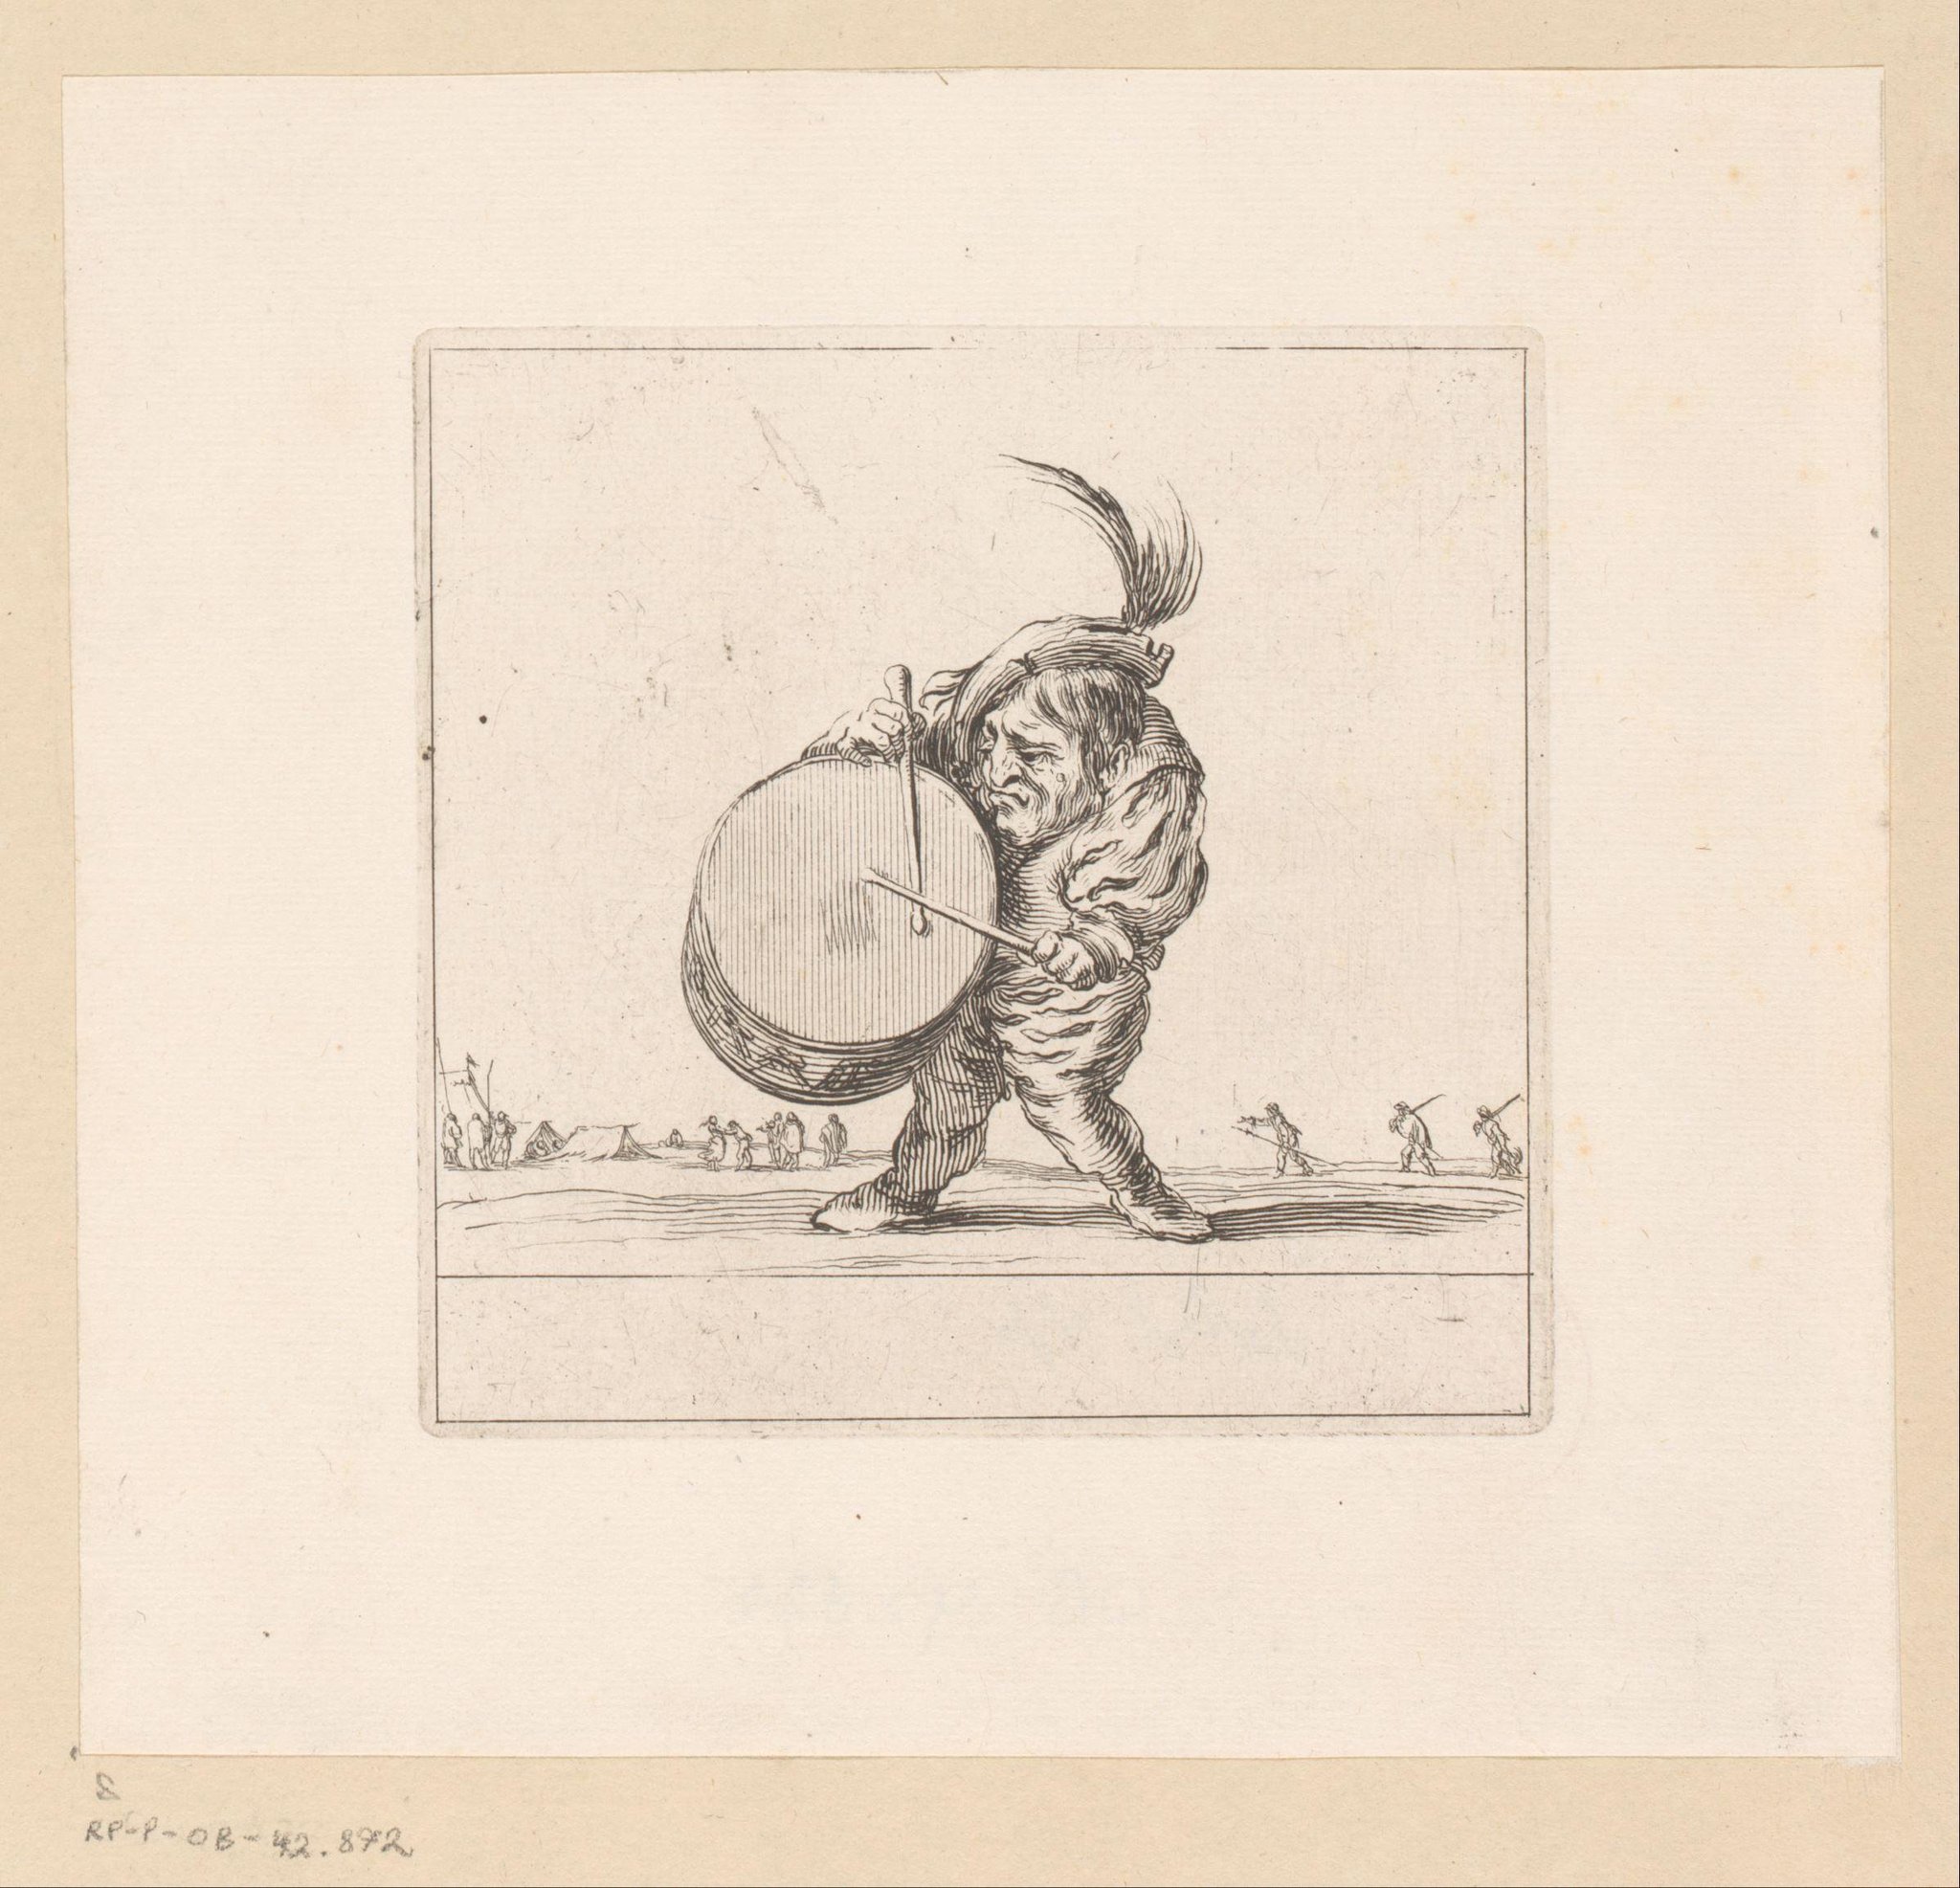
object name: print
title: Karikatuur van een trommelspelende man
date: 1620-1687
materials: paper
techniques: engraving, etching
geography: paris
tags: caricatures (human types), making music; musician with instrument - cc - out of doors, drum (musical instrument) - cc - out of doors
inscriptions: collector's mark: Lugt 240